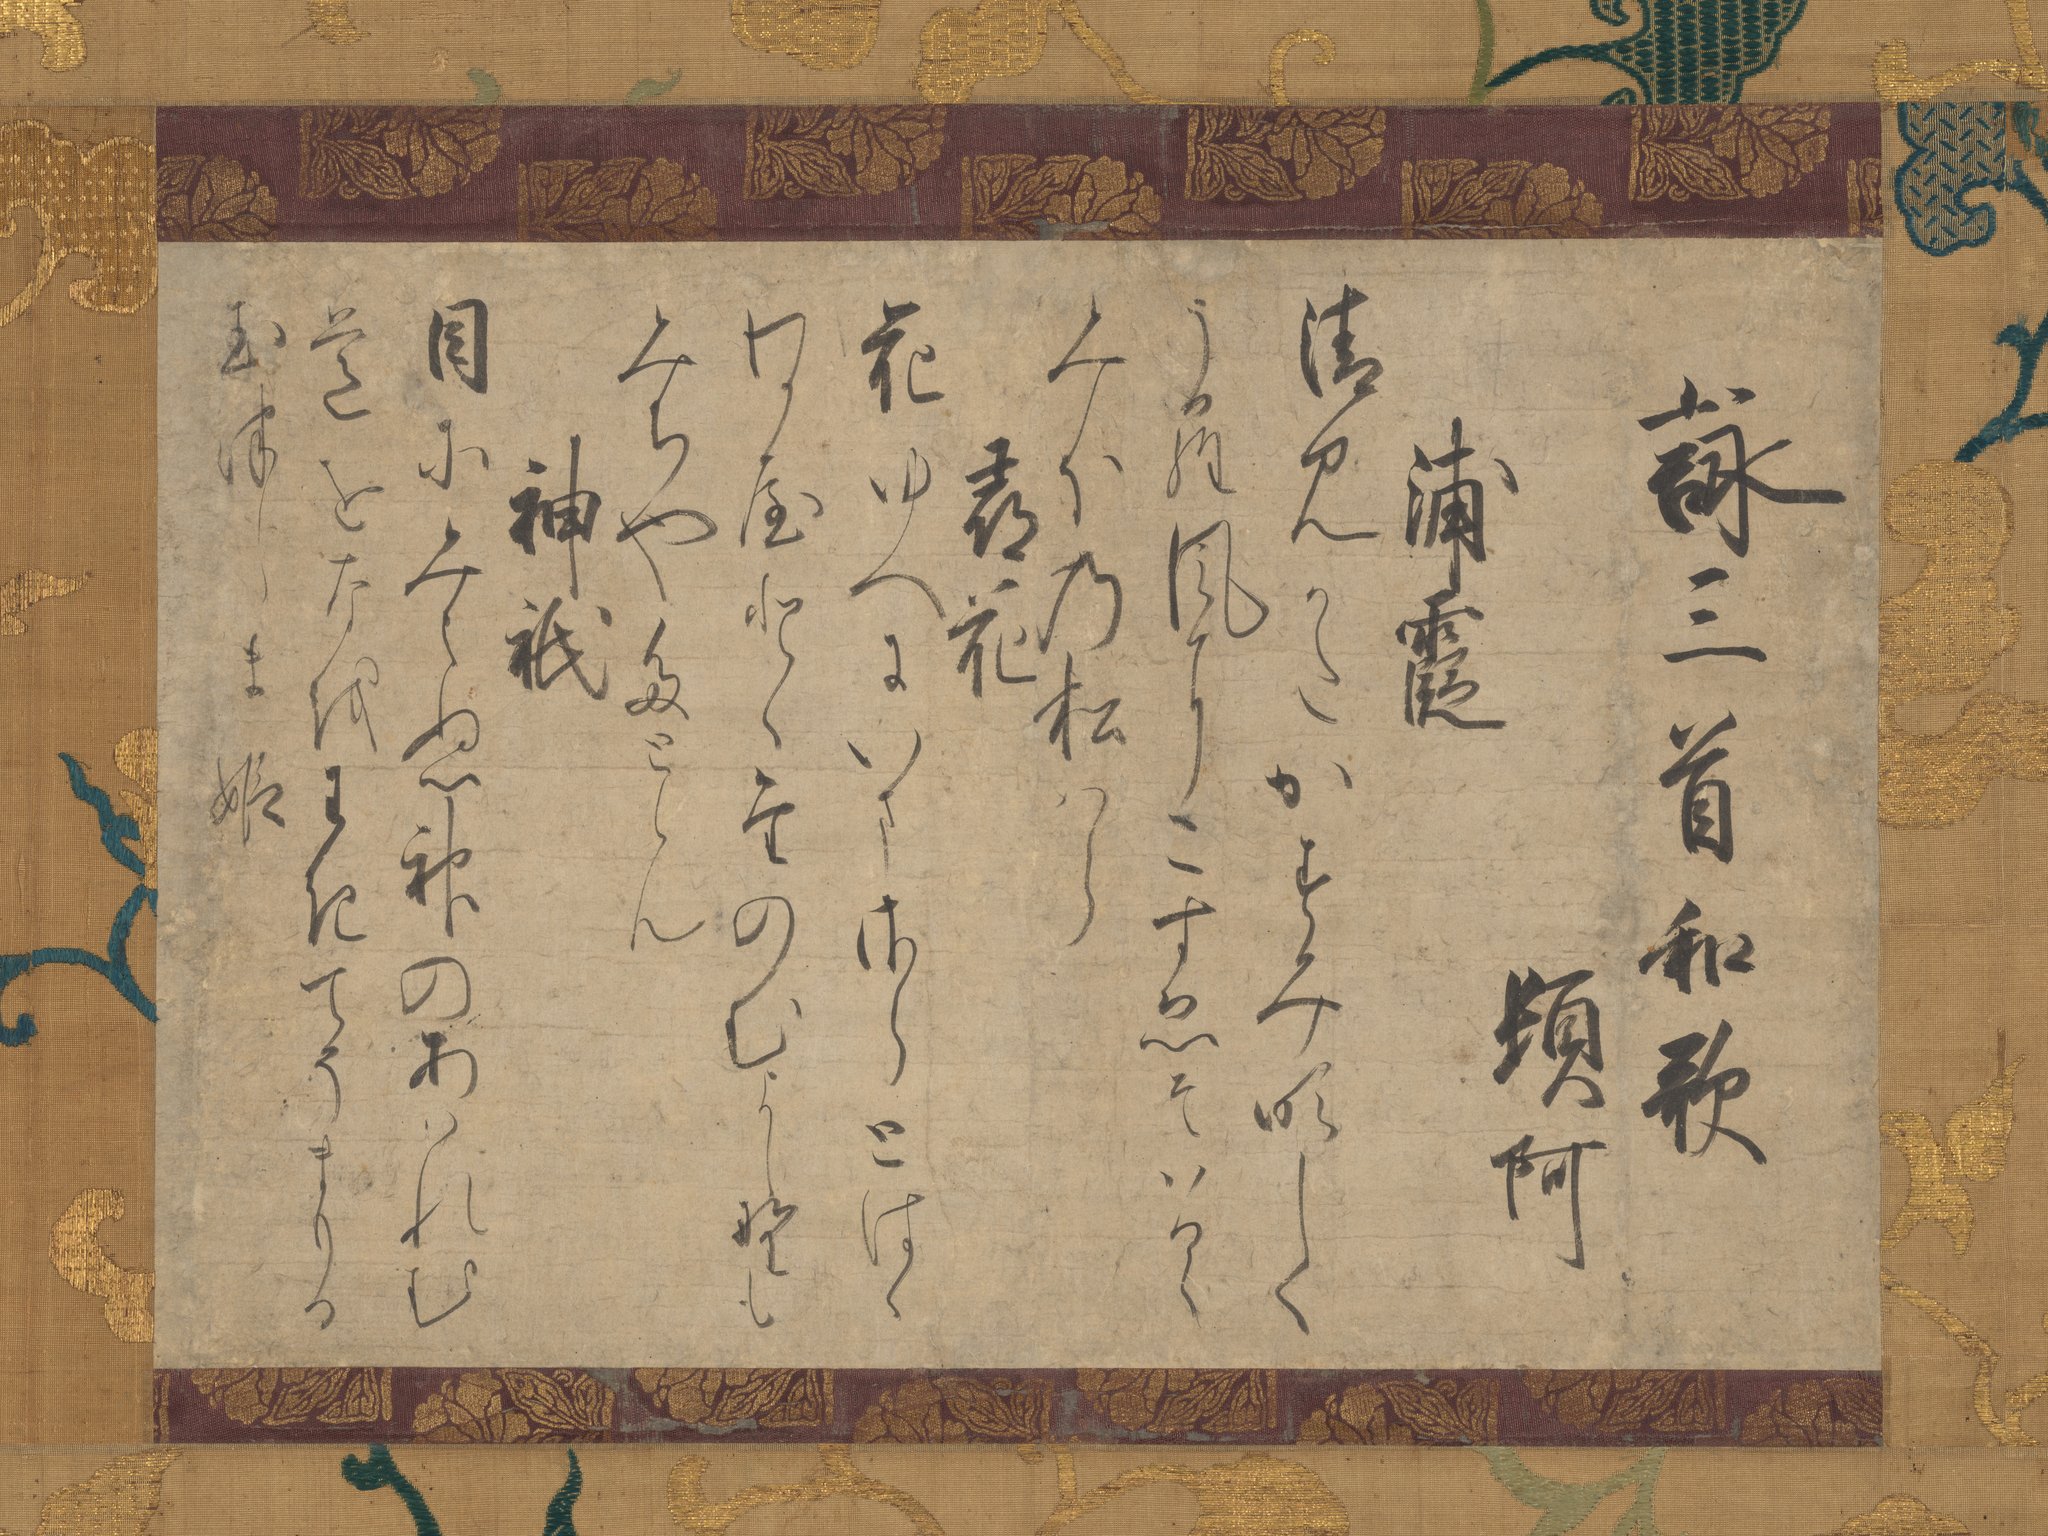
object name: hanging scroll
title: Three Waka Poems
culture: japanese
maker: tonna (ton’a)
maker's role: artist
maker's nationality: japanese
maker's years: 1289-1372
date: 1368-1369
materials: ink, paper